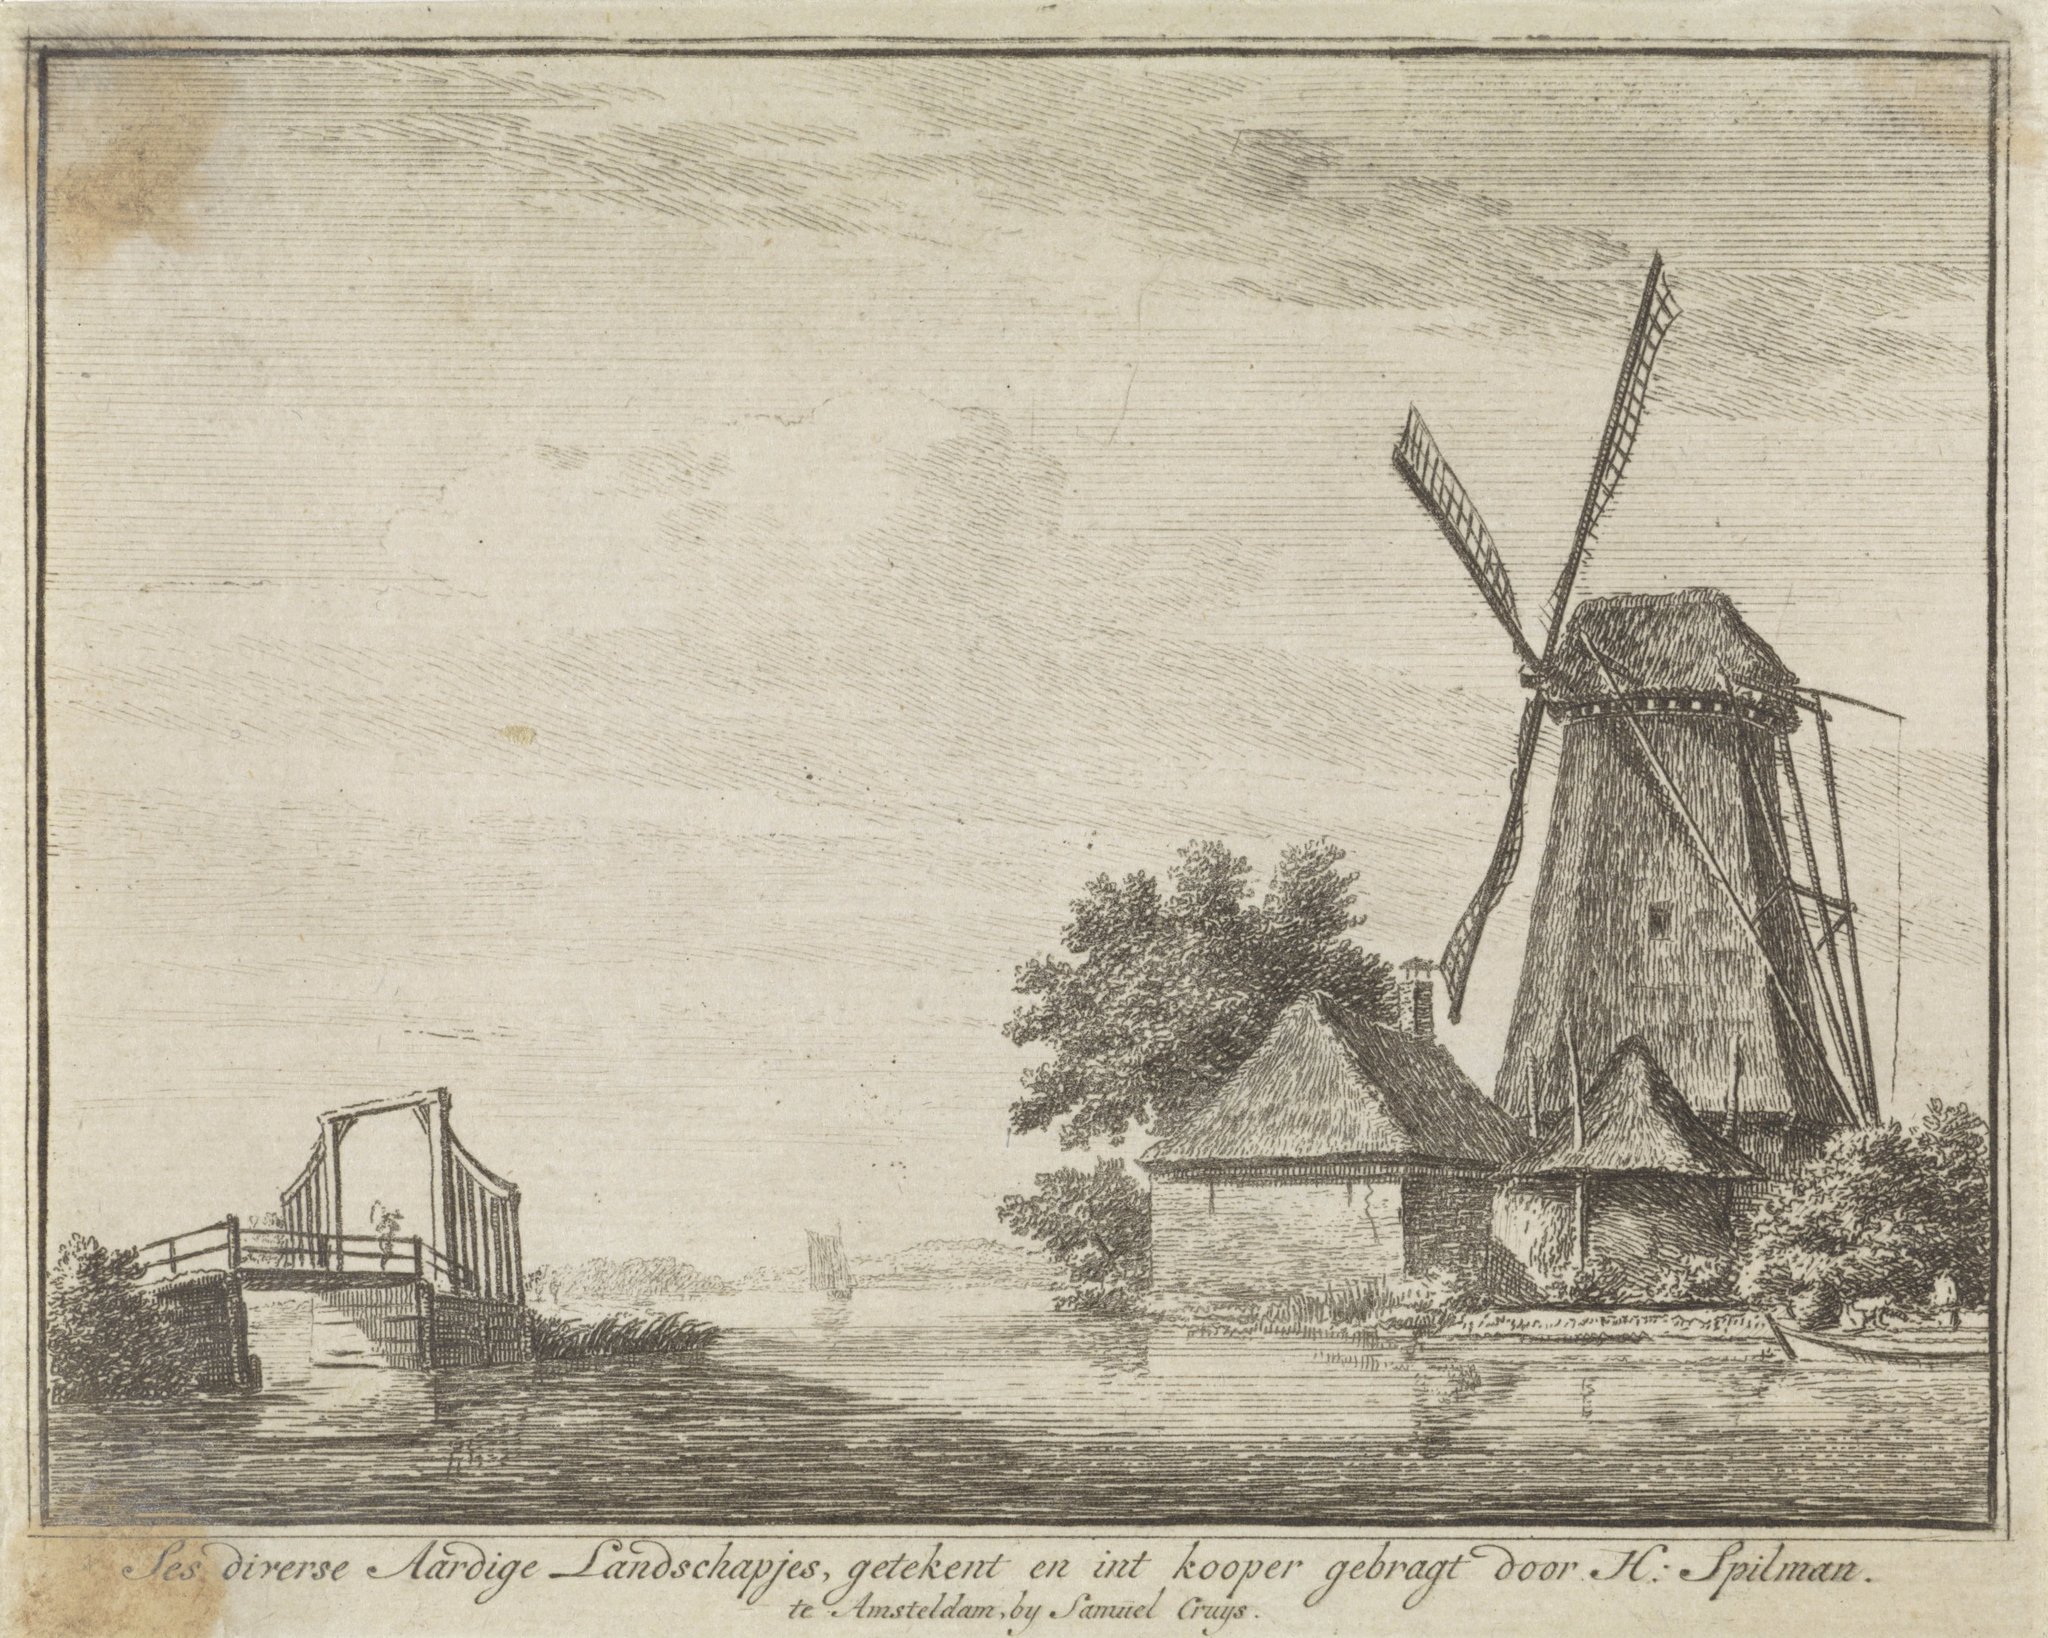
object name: titelprent, frontispice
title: Rivierlandschap met een molen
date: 1742-1784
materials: paper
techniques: etching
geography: amsterdam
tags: river, landscape with bridge, viaduct or aqueduct, windmill in landscape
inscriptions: collector's mark: Lugt 2228